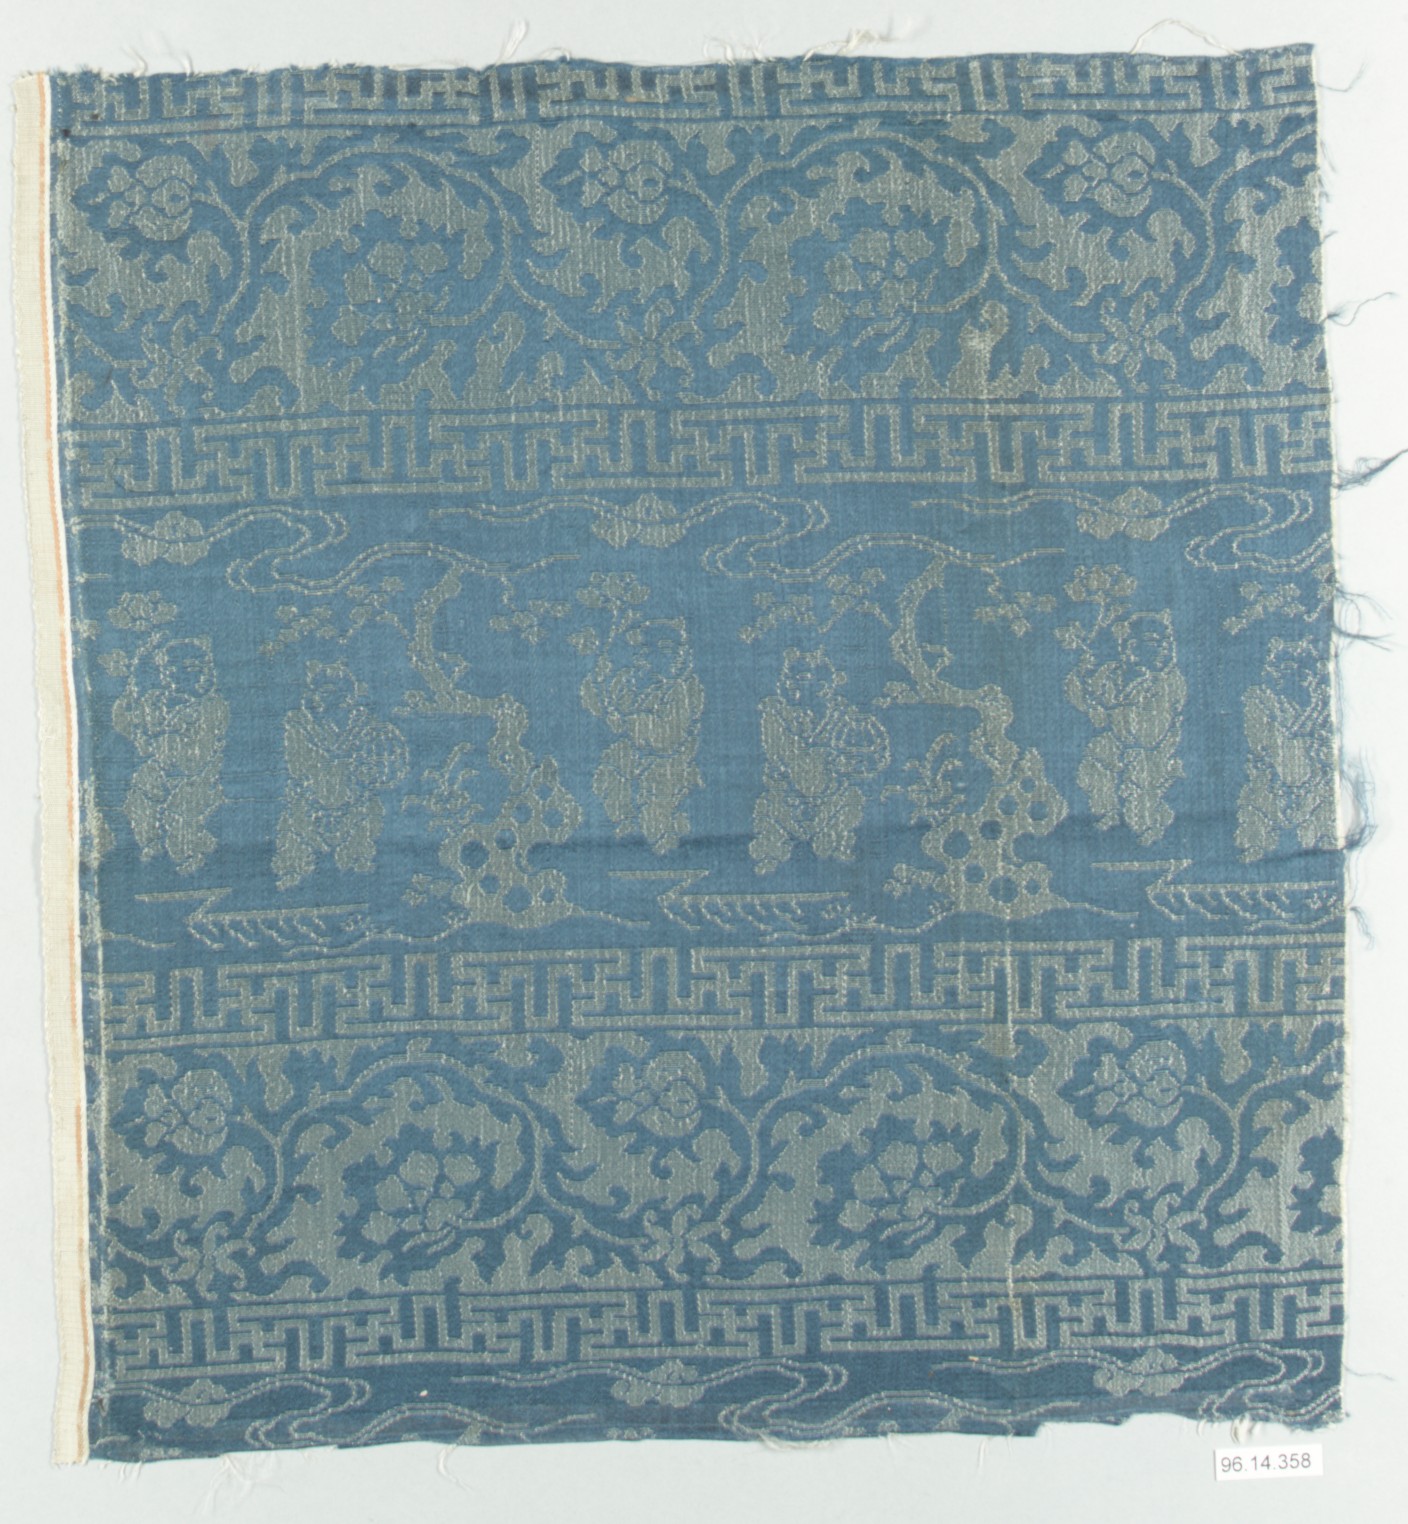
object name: piece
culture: japanese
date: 1701-1900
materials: silk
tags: boys